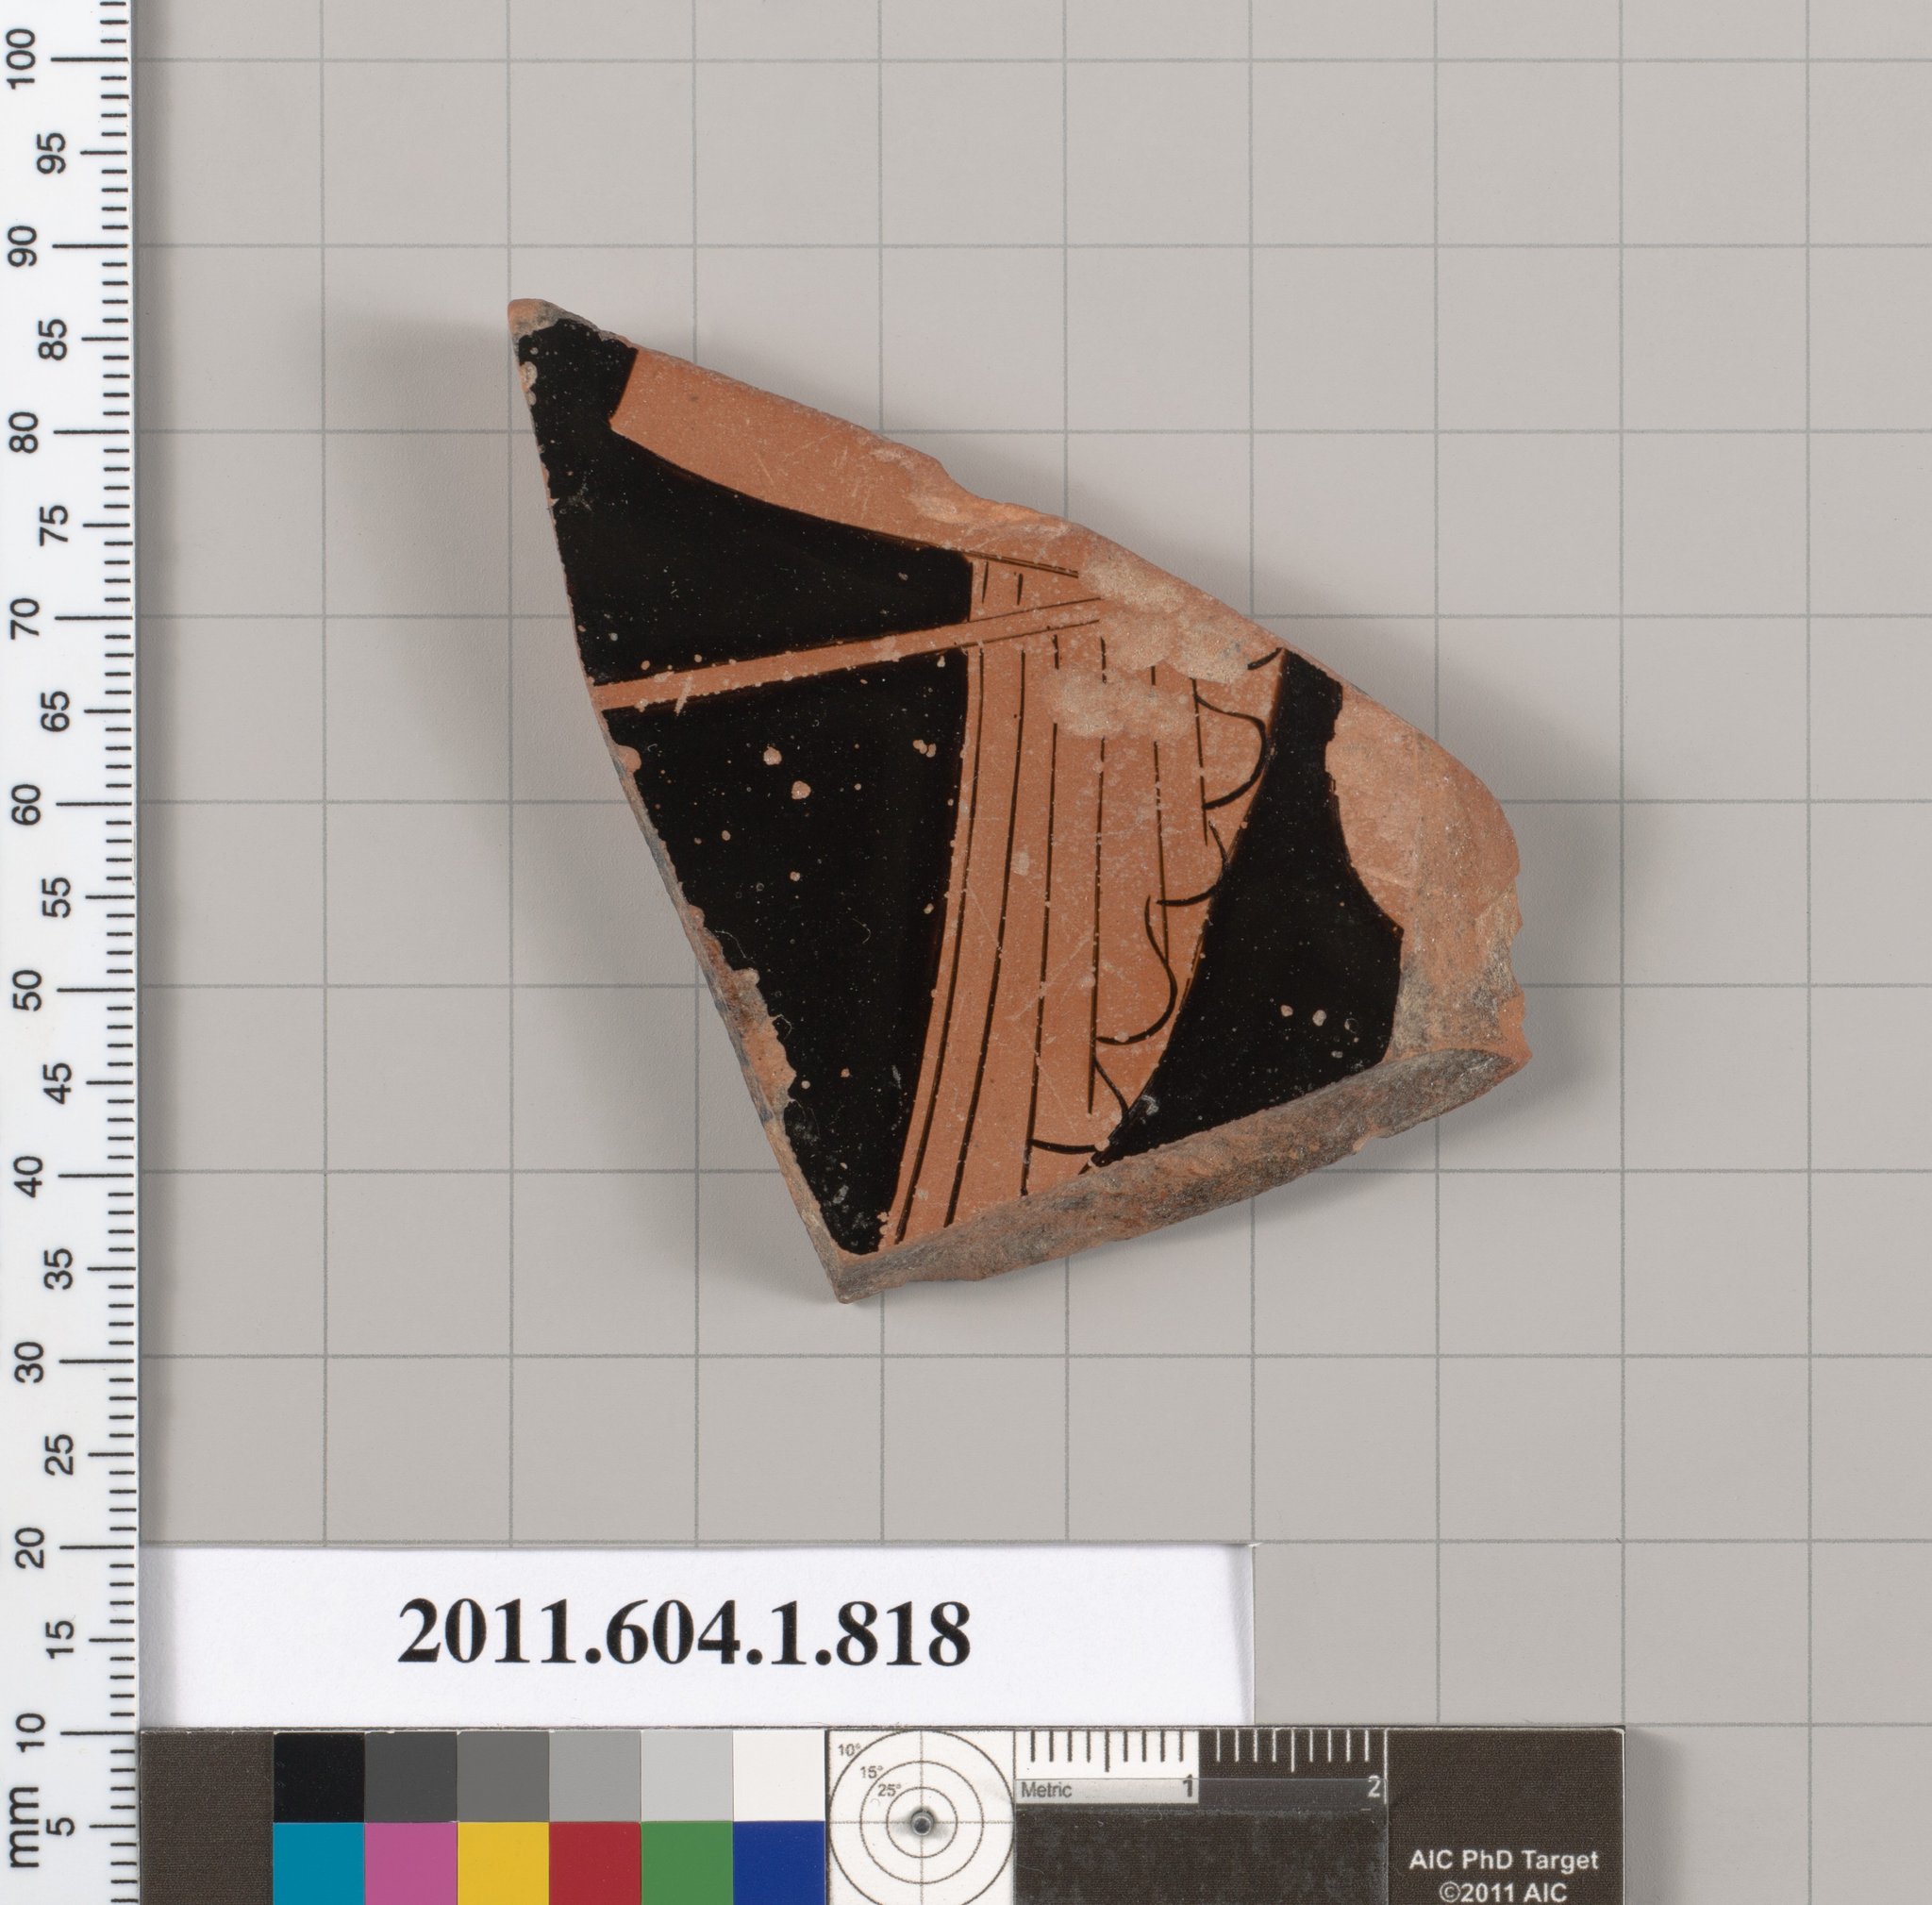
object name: kylix fragment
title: Terracotta fragment of a kylix (drinking cup)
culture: greek, attic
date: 475-451 BCE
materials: terracotta